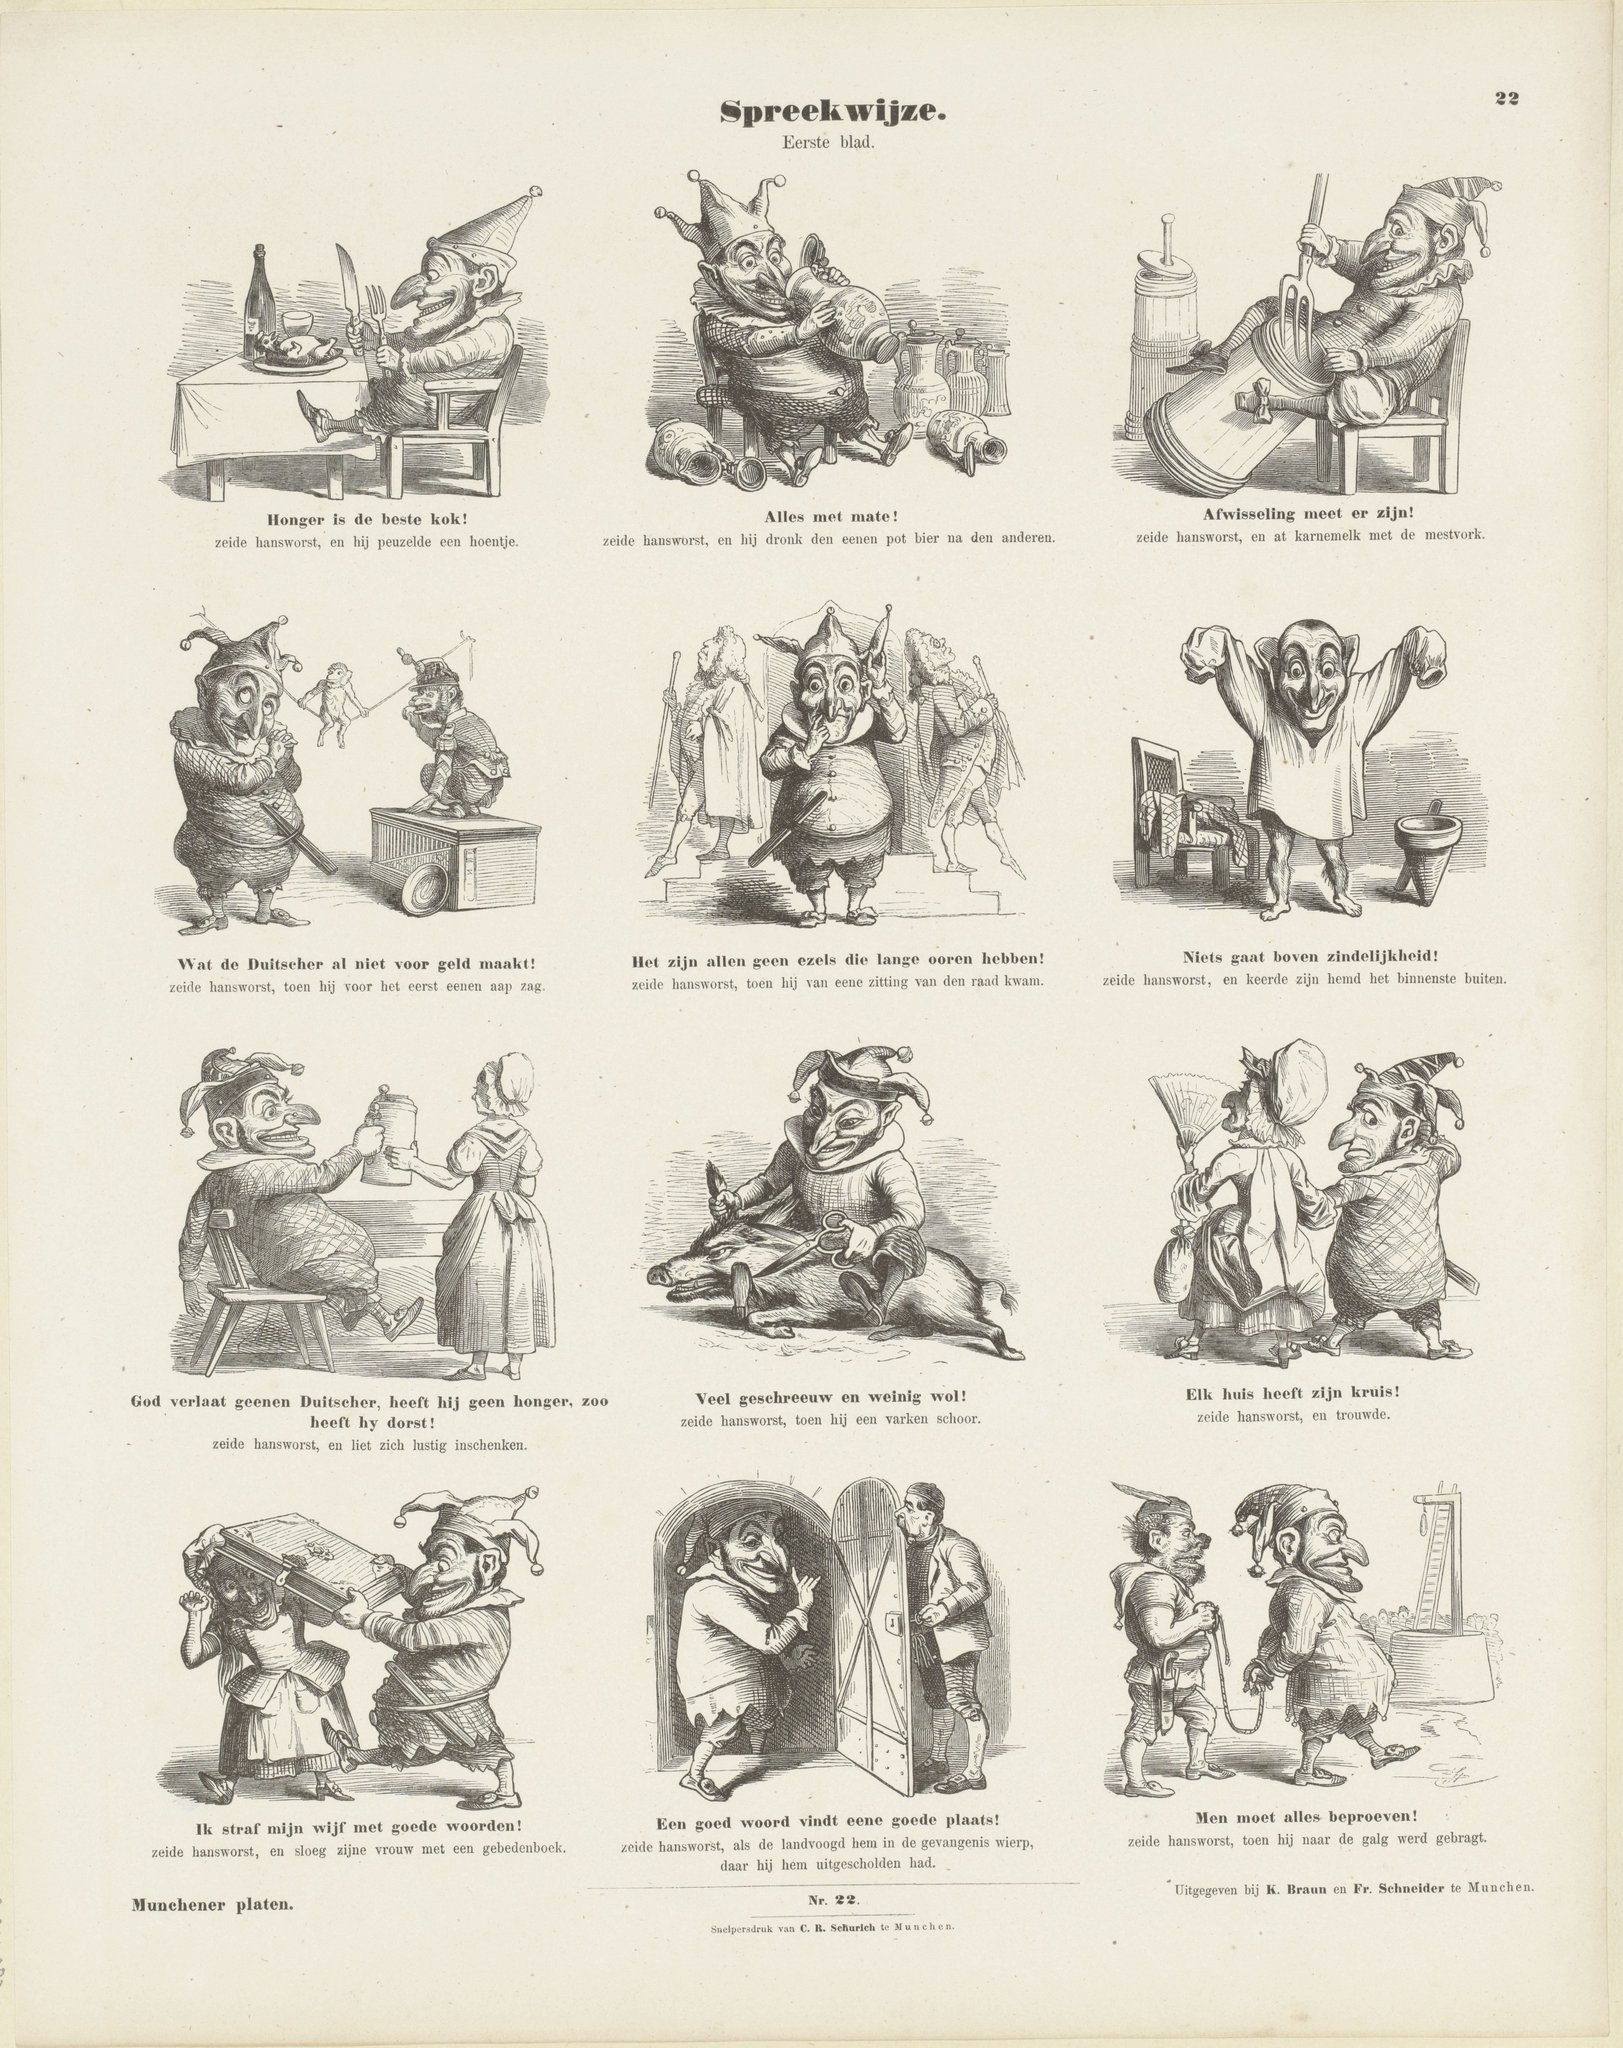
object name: print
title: Spreekwijze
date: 1843-1920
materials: paper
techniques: letterpress printing, engraving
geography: germany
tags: fool, simpleton, numskull, proverbs, sayings, etc.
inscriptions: collector's mark: Lugt 2760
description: Blad met 12 verbeeldingen van spreekwoorden door komische taferelen met Hansworst. Onder elke afbeelding een onderschrift. Genummerd midden onder: Nr. 22. Genummerd rechtsboven: 22.